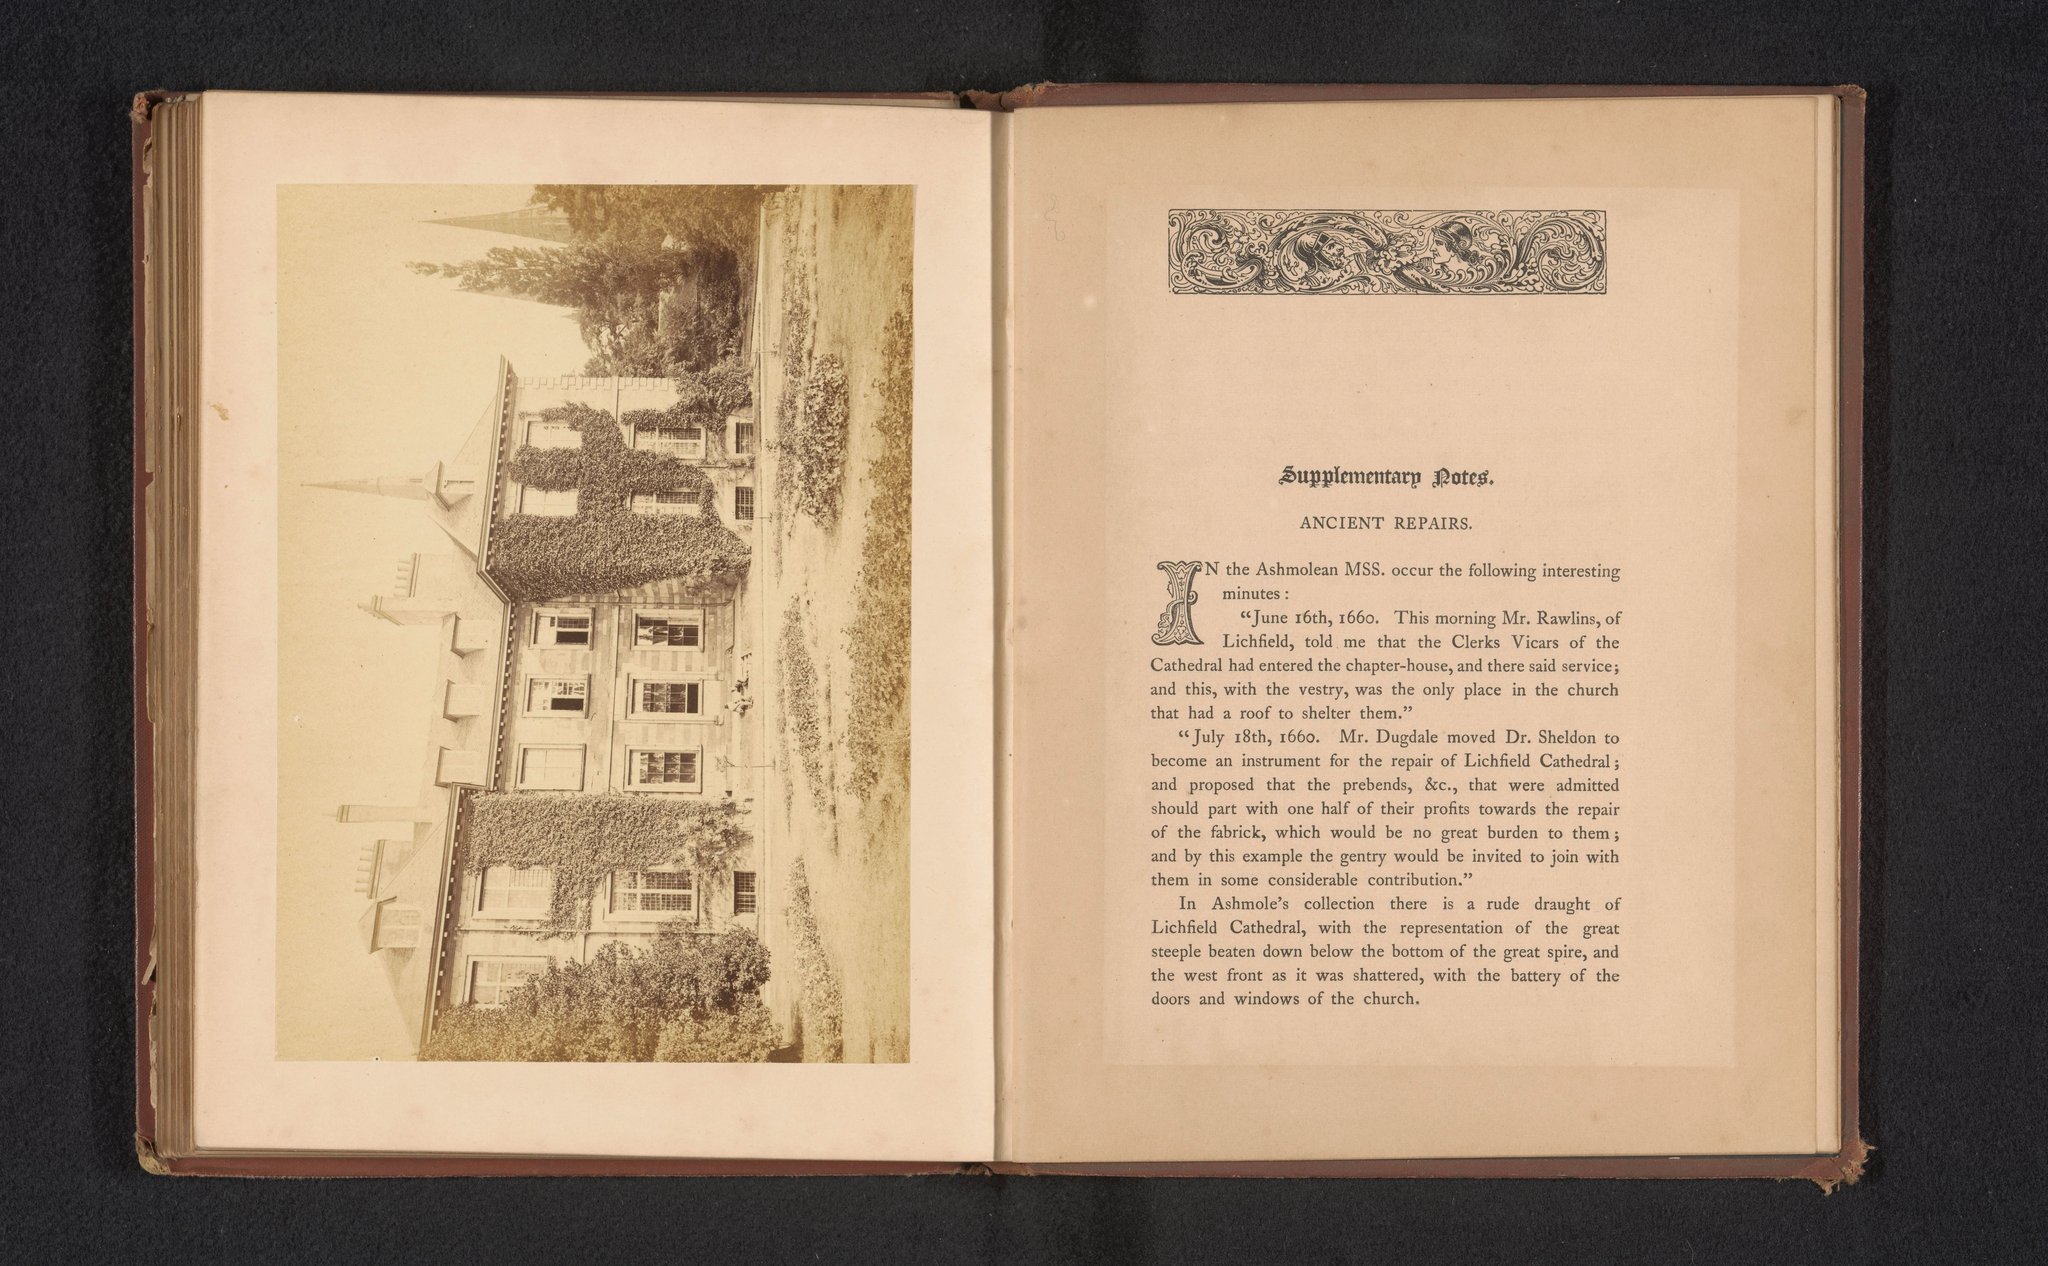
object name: photograph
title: Gezicht op Bishop's Palace te Lichfield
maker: john benjamin stone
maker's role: politician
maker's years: 1838-1914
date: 1865-1870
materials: photographic support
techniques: albumen print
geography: lichfield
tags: façade (of house or building)